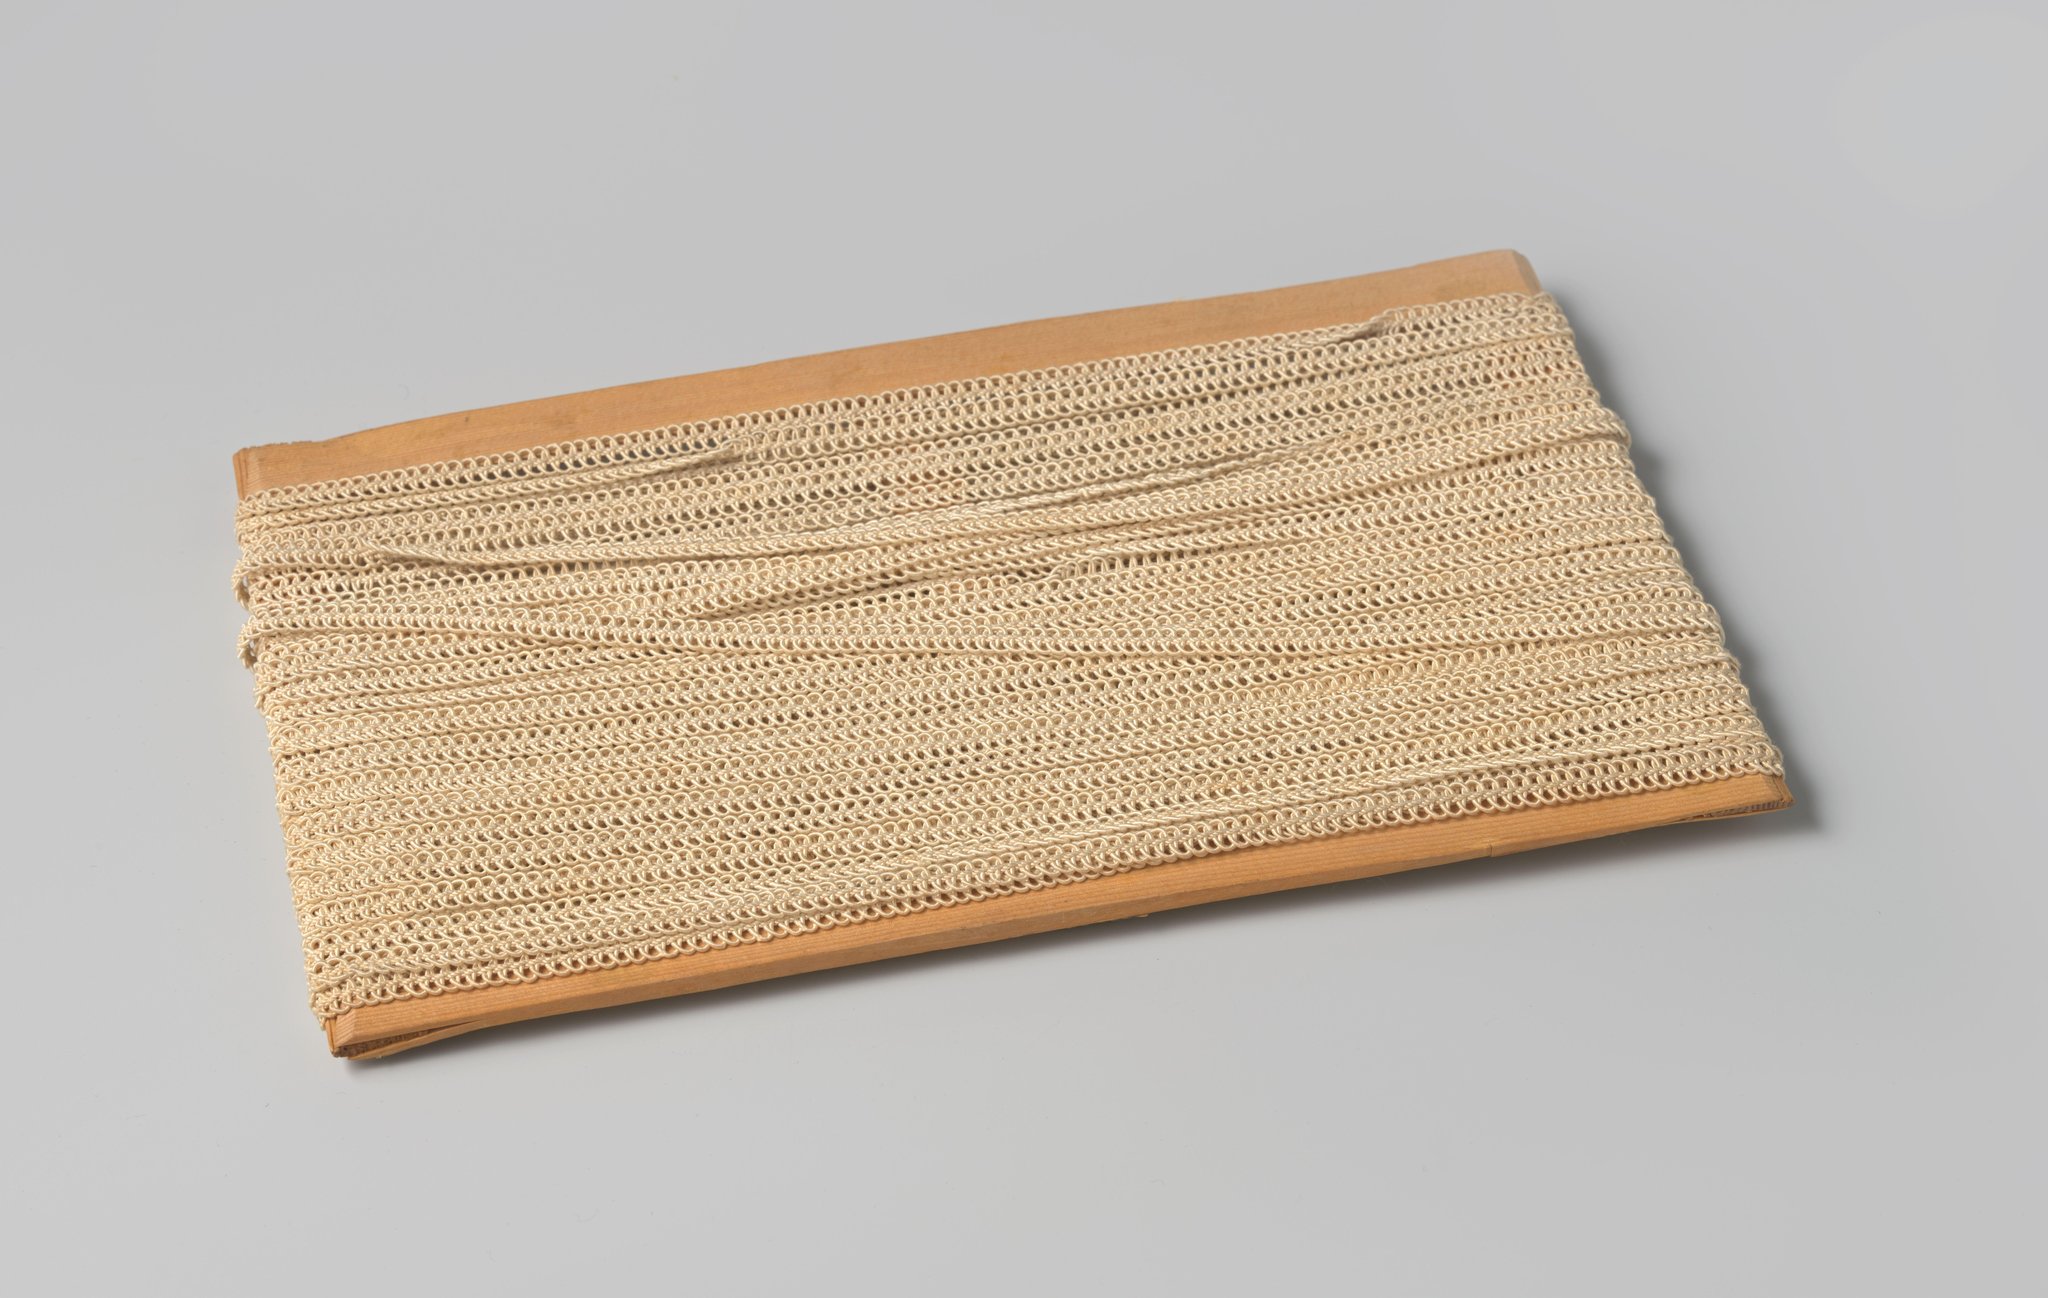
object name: braid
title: Passement van glanzend roomwit koord waardoorheen lussen zijn gevlochten, op houten frame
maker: gustav schnitzler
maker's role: paraplufabrikant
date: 1925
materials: wood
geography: nijmegen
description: Passement van glanzend roomwit koord waardoorheen lussen zijn gevlochten, op houten frame.